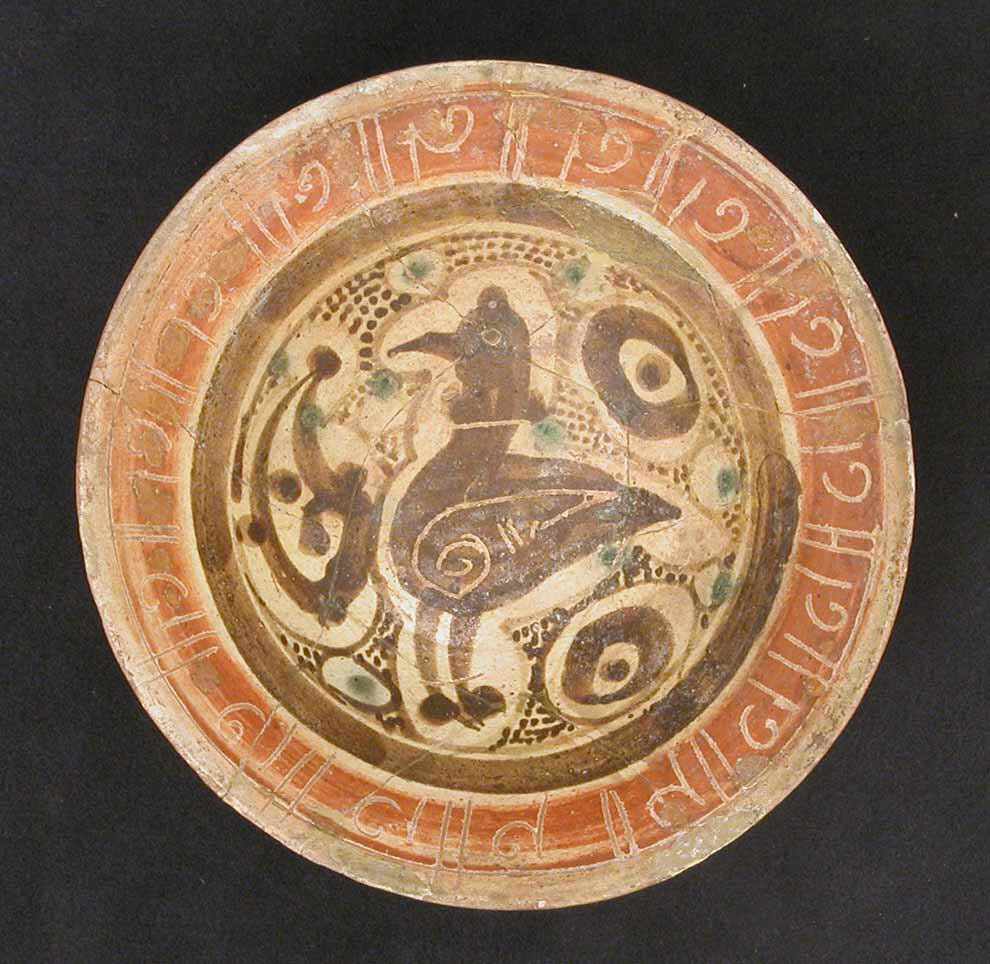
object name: bowl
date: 901-1000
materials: earthenware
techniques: glazing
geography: turkmenistan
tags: birds